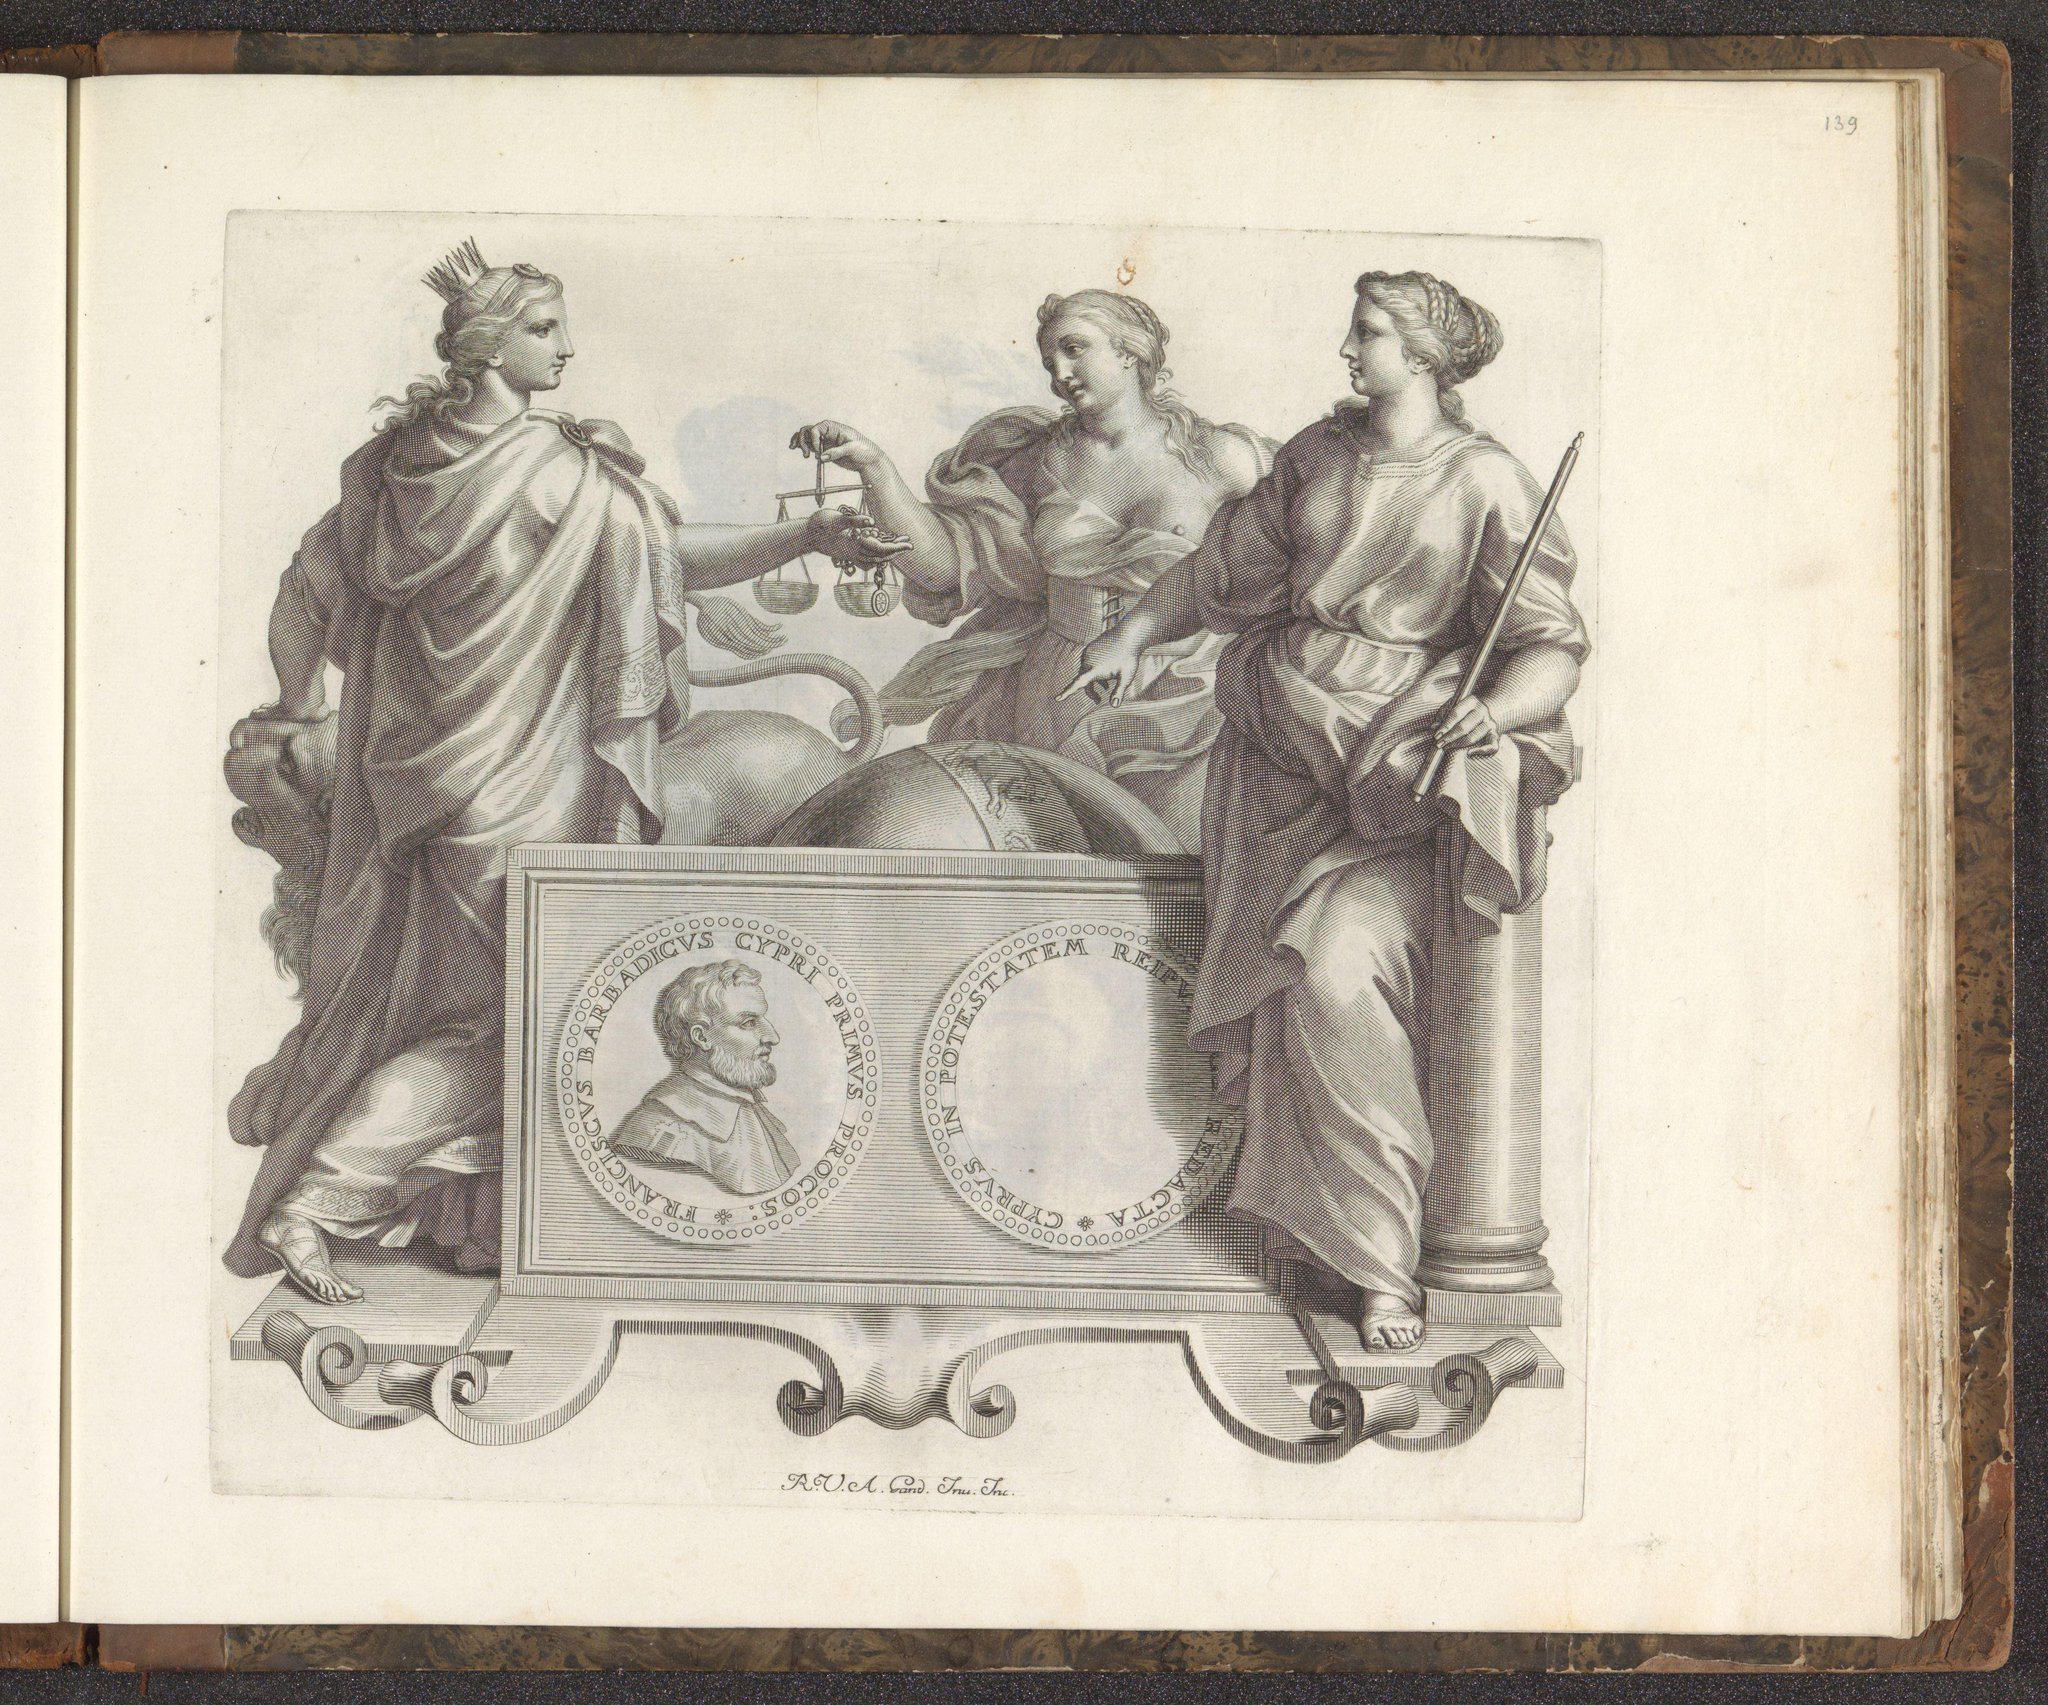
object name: album leaf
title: Portret van Francesco Barbarigo en de personificaties van onder meer Vrijgevigheid en Politiek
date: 1673-1743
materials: paper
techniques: engraving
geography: rome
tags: scales, medal (considered as a piece of sculpture, regardless of its specific function), government, the state; 'politica', 'auttorità o potestà' (ripa), beasts of prey, predatory animals: lion, generosity, liberality; 'generosità', 'liberalità' (ripa)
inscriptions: collector's mark: Lugt 2228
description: Voetstuk in de vorm van een cartouche. Daarop een medaillon met op de voorzijde het portret van Francesco Barbarigo. Op de achterkant een leeg veld met de tekst: Cyprus in Potestatem Reipublicae Redacta. Het voetstuk wordt omringd door drie personificaties. Links staat Vrijgevigheid. De vrouw met kroon op het hoofd reikt een gouden ketting aan. Haar linkerhand ligt op de kop van een leeuw. In het midden staat Politiek met weegschaal. De vrouw rechts heeft een roede en leunt met haar arm op een pilaar. Ze wijst naar een globe met de tekens van de dierenriem. De prent maakt deel uit van een album.